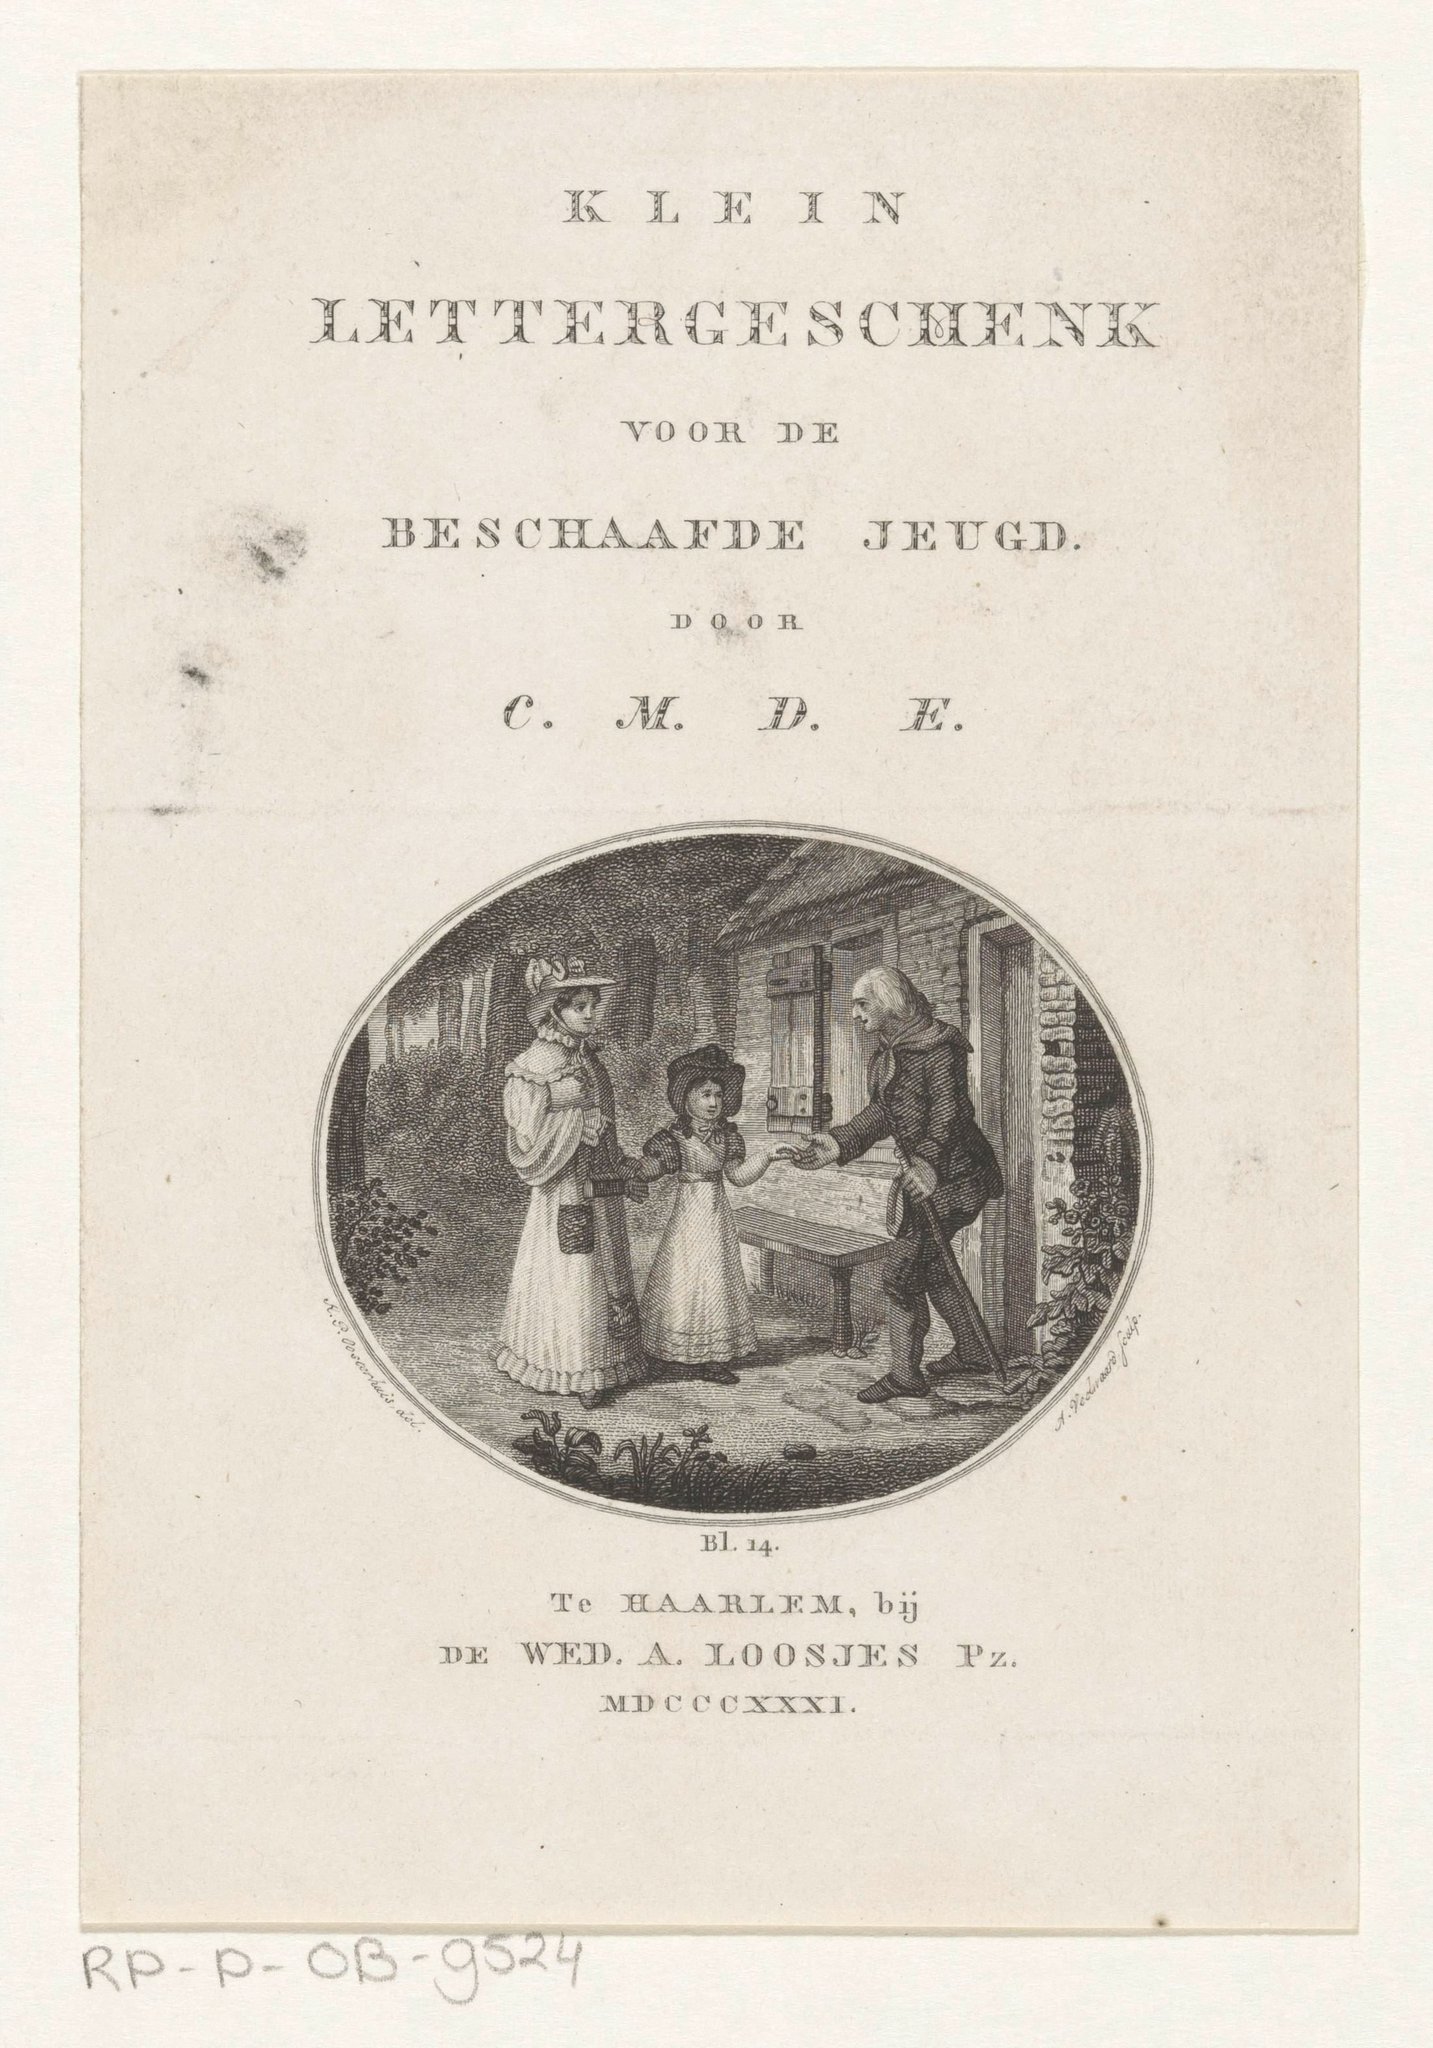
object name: print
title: Vrouw en meisje bezoeken oude man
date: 1831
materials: paper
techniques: engraving, etching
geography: haarlem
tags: visiting; receiving guests; elegant company, old man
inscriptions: collector's mark: Lugt 2228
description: Titelpagina voor: Dóll-Egges, Catharina Maria. Klein lettergeschenk voor de beschaafde jeugd. Haarlem: Loosjes Pz., weduwe Adriaan, 1831.